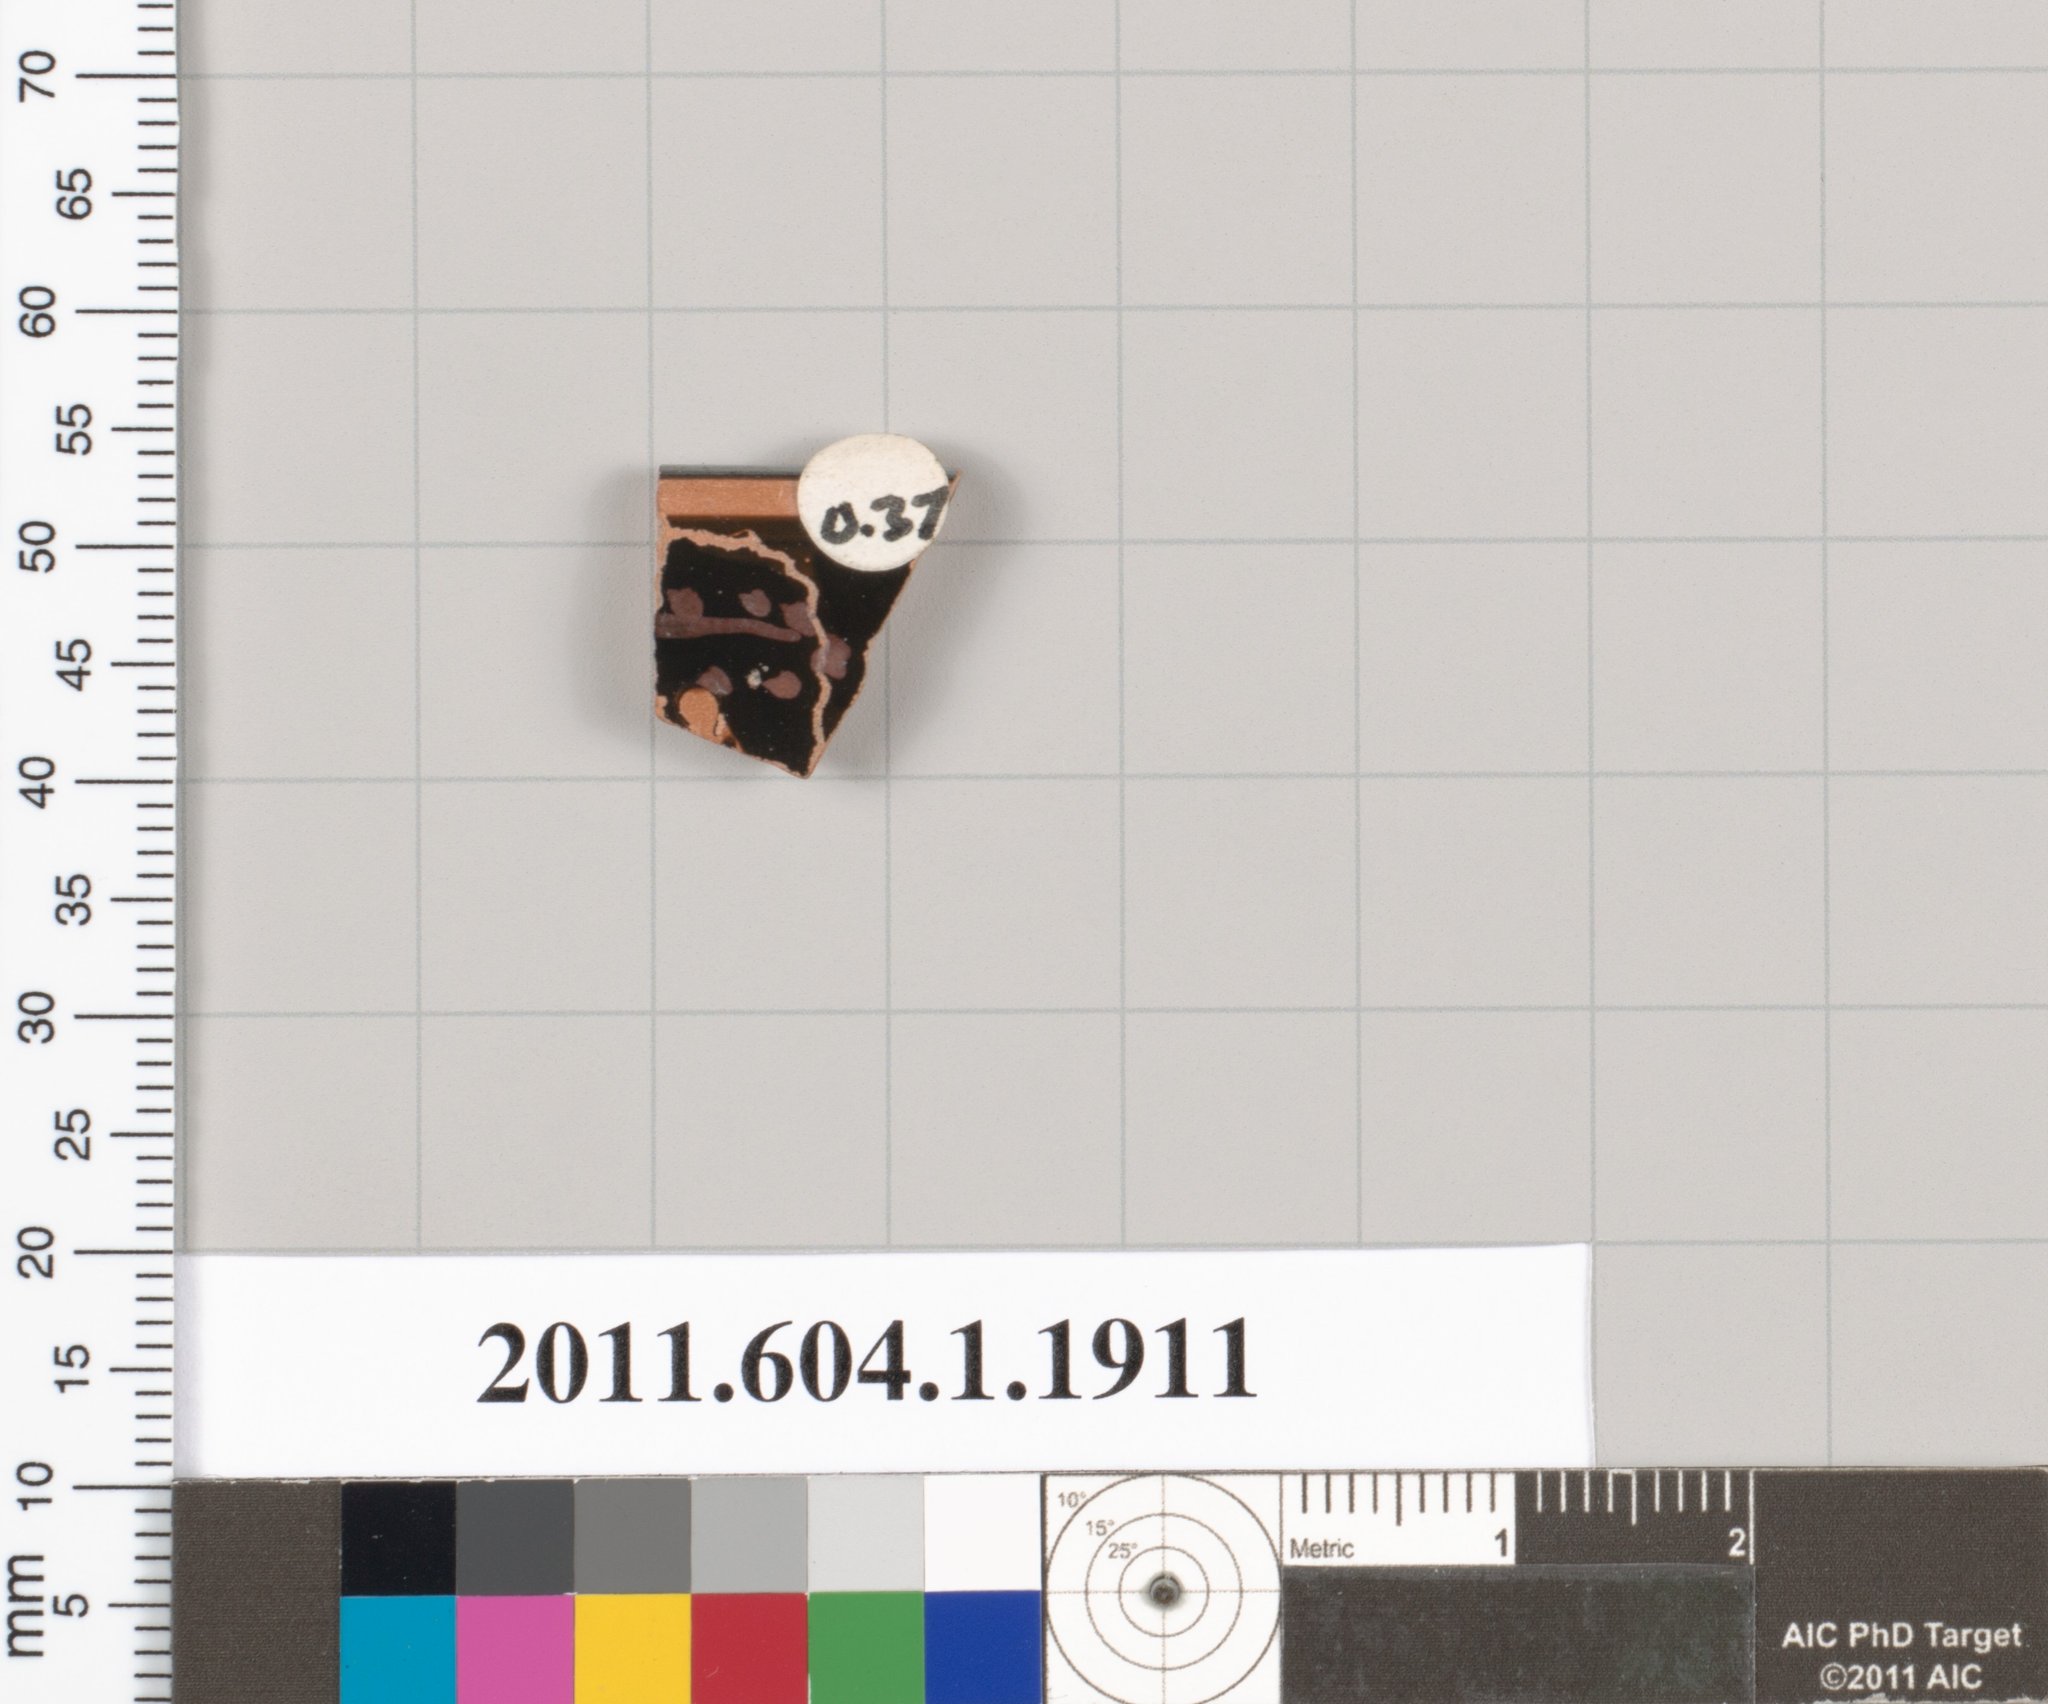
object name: kylix fragment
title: Terracotta rim fragment of a kylix (drinking cup)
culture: greek, attic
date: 534-501 BCE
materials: terracotta